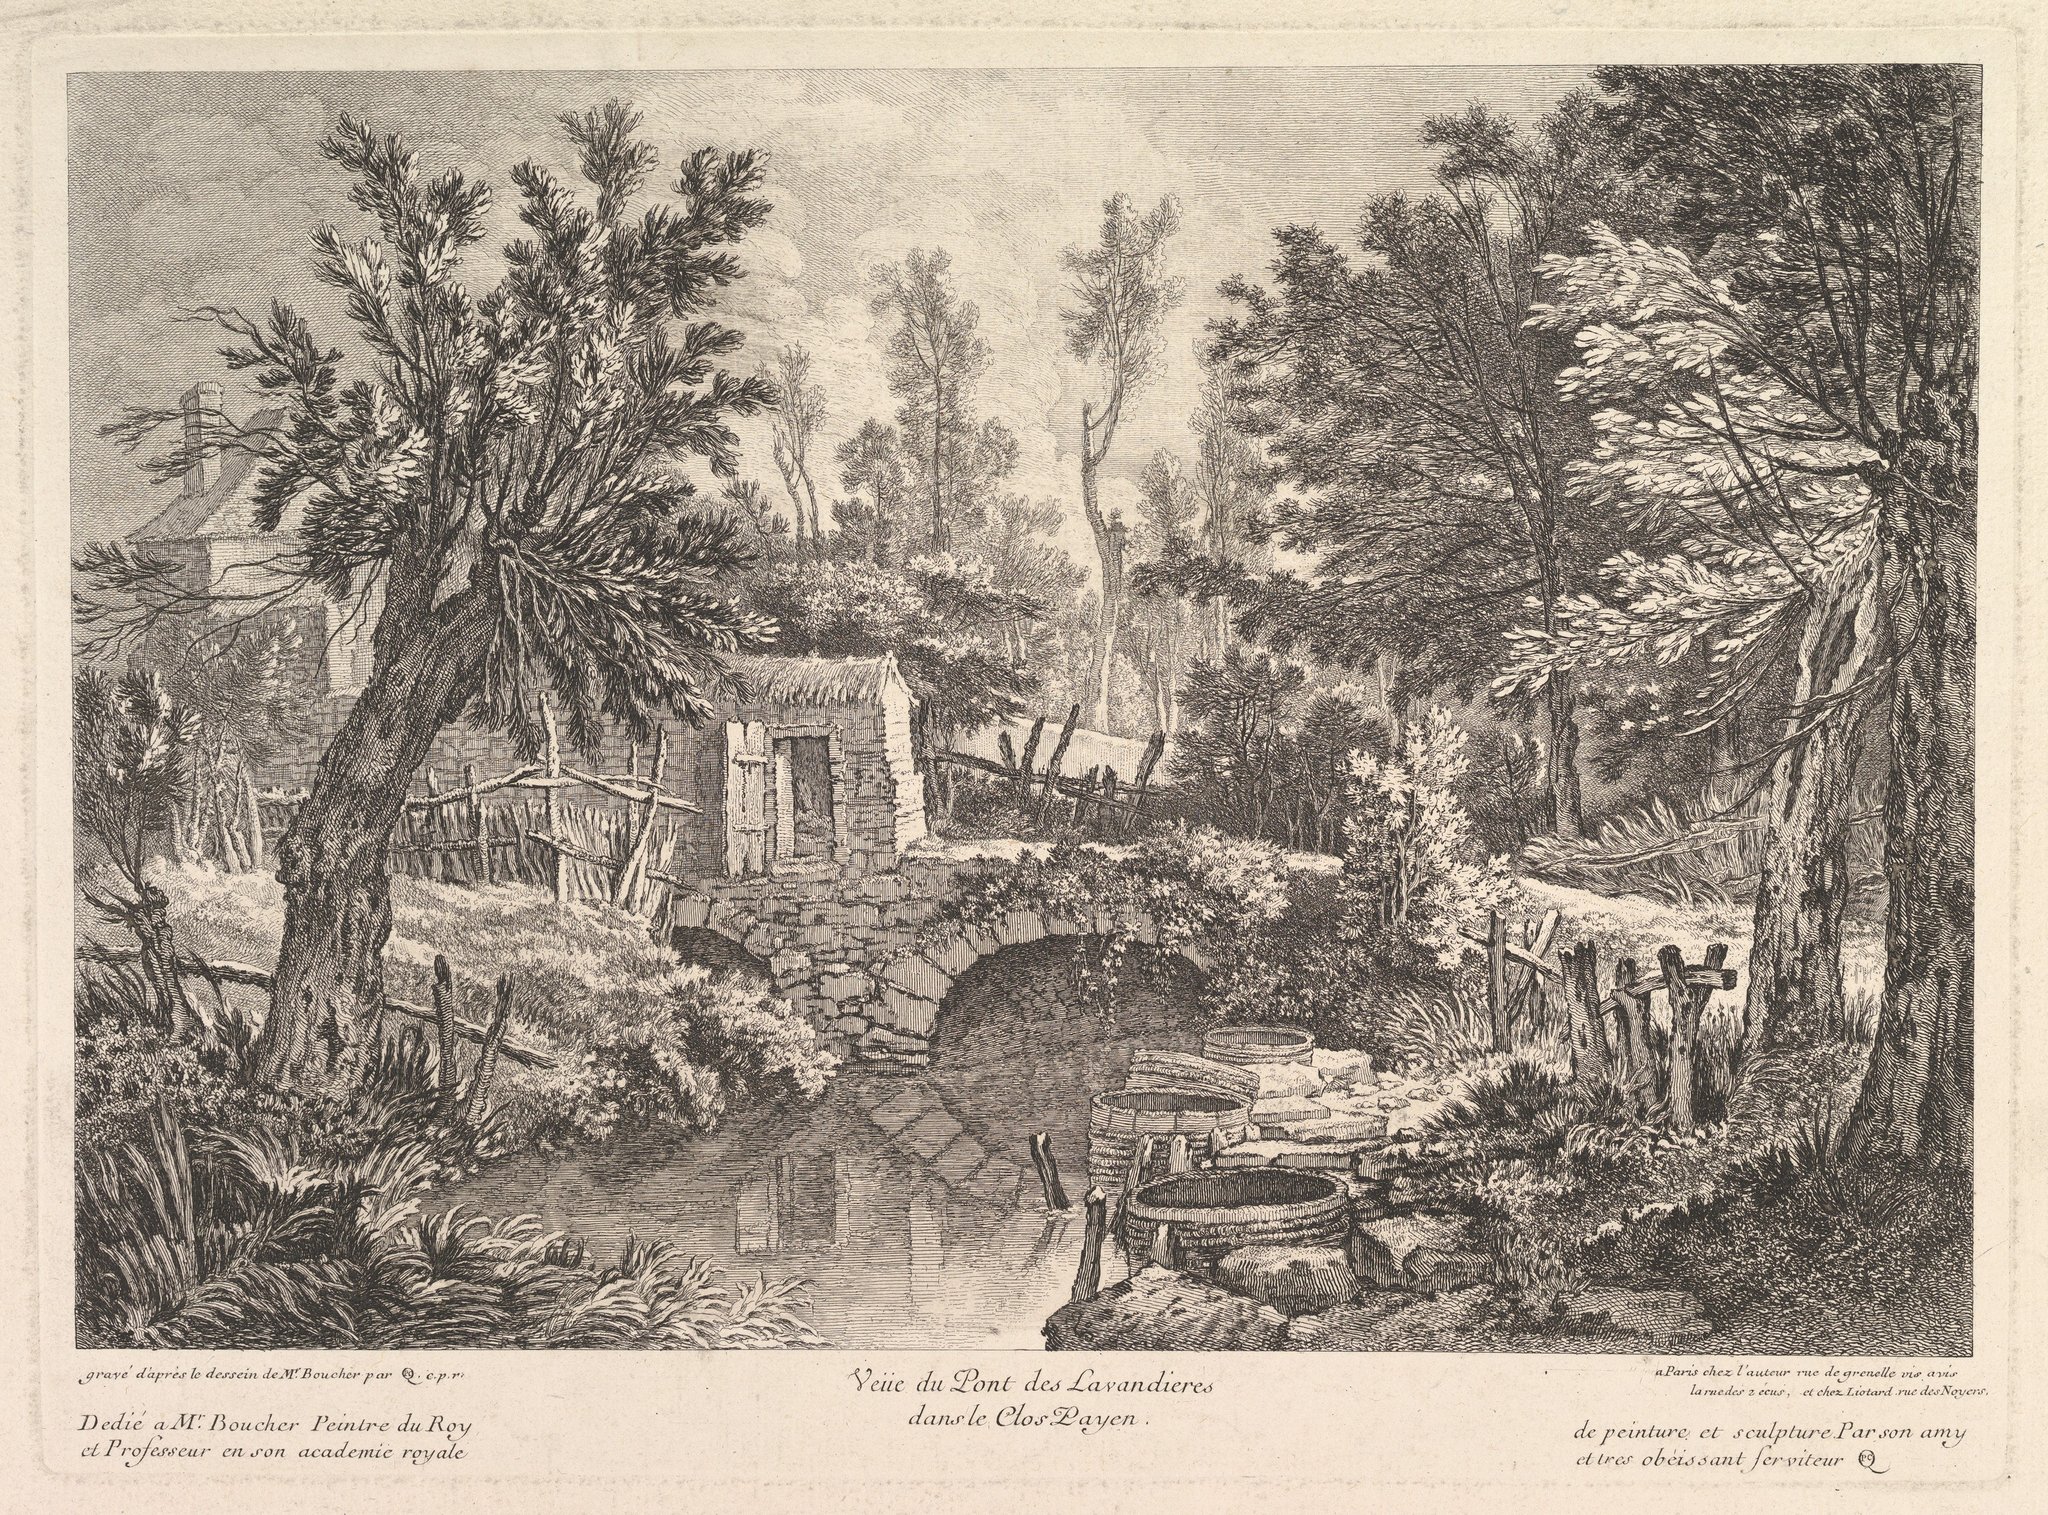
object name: print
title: View of the Lavandieres Bridge at the Peasant House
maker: quentin pierre chedel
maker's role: artist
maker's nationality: french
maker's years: 1705-1763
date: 1734-1766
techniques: etching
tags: houses,bridges,landscapes